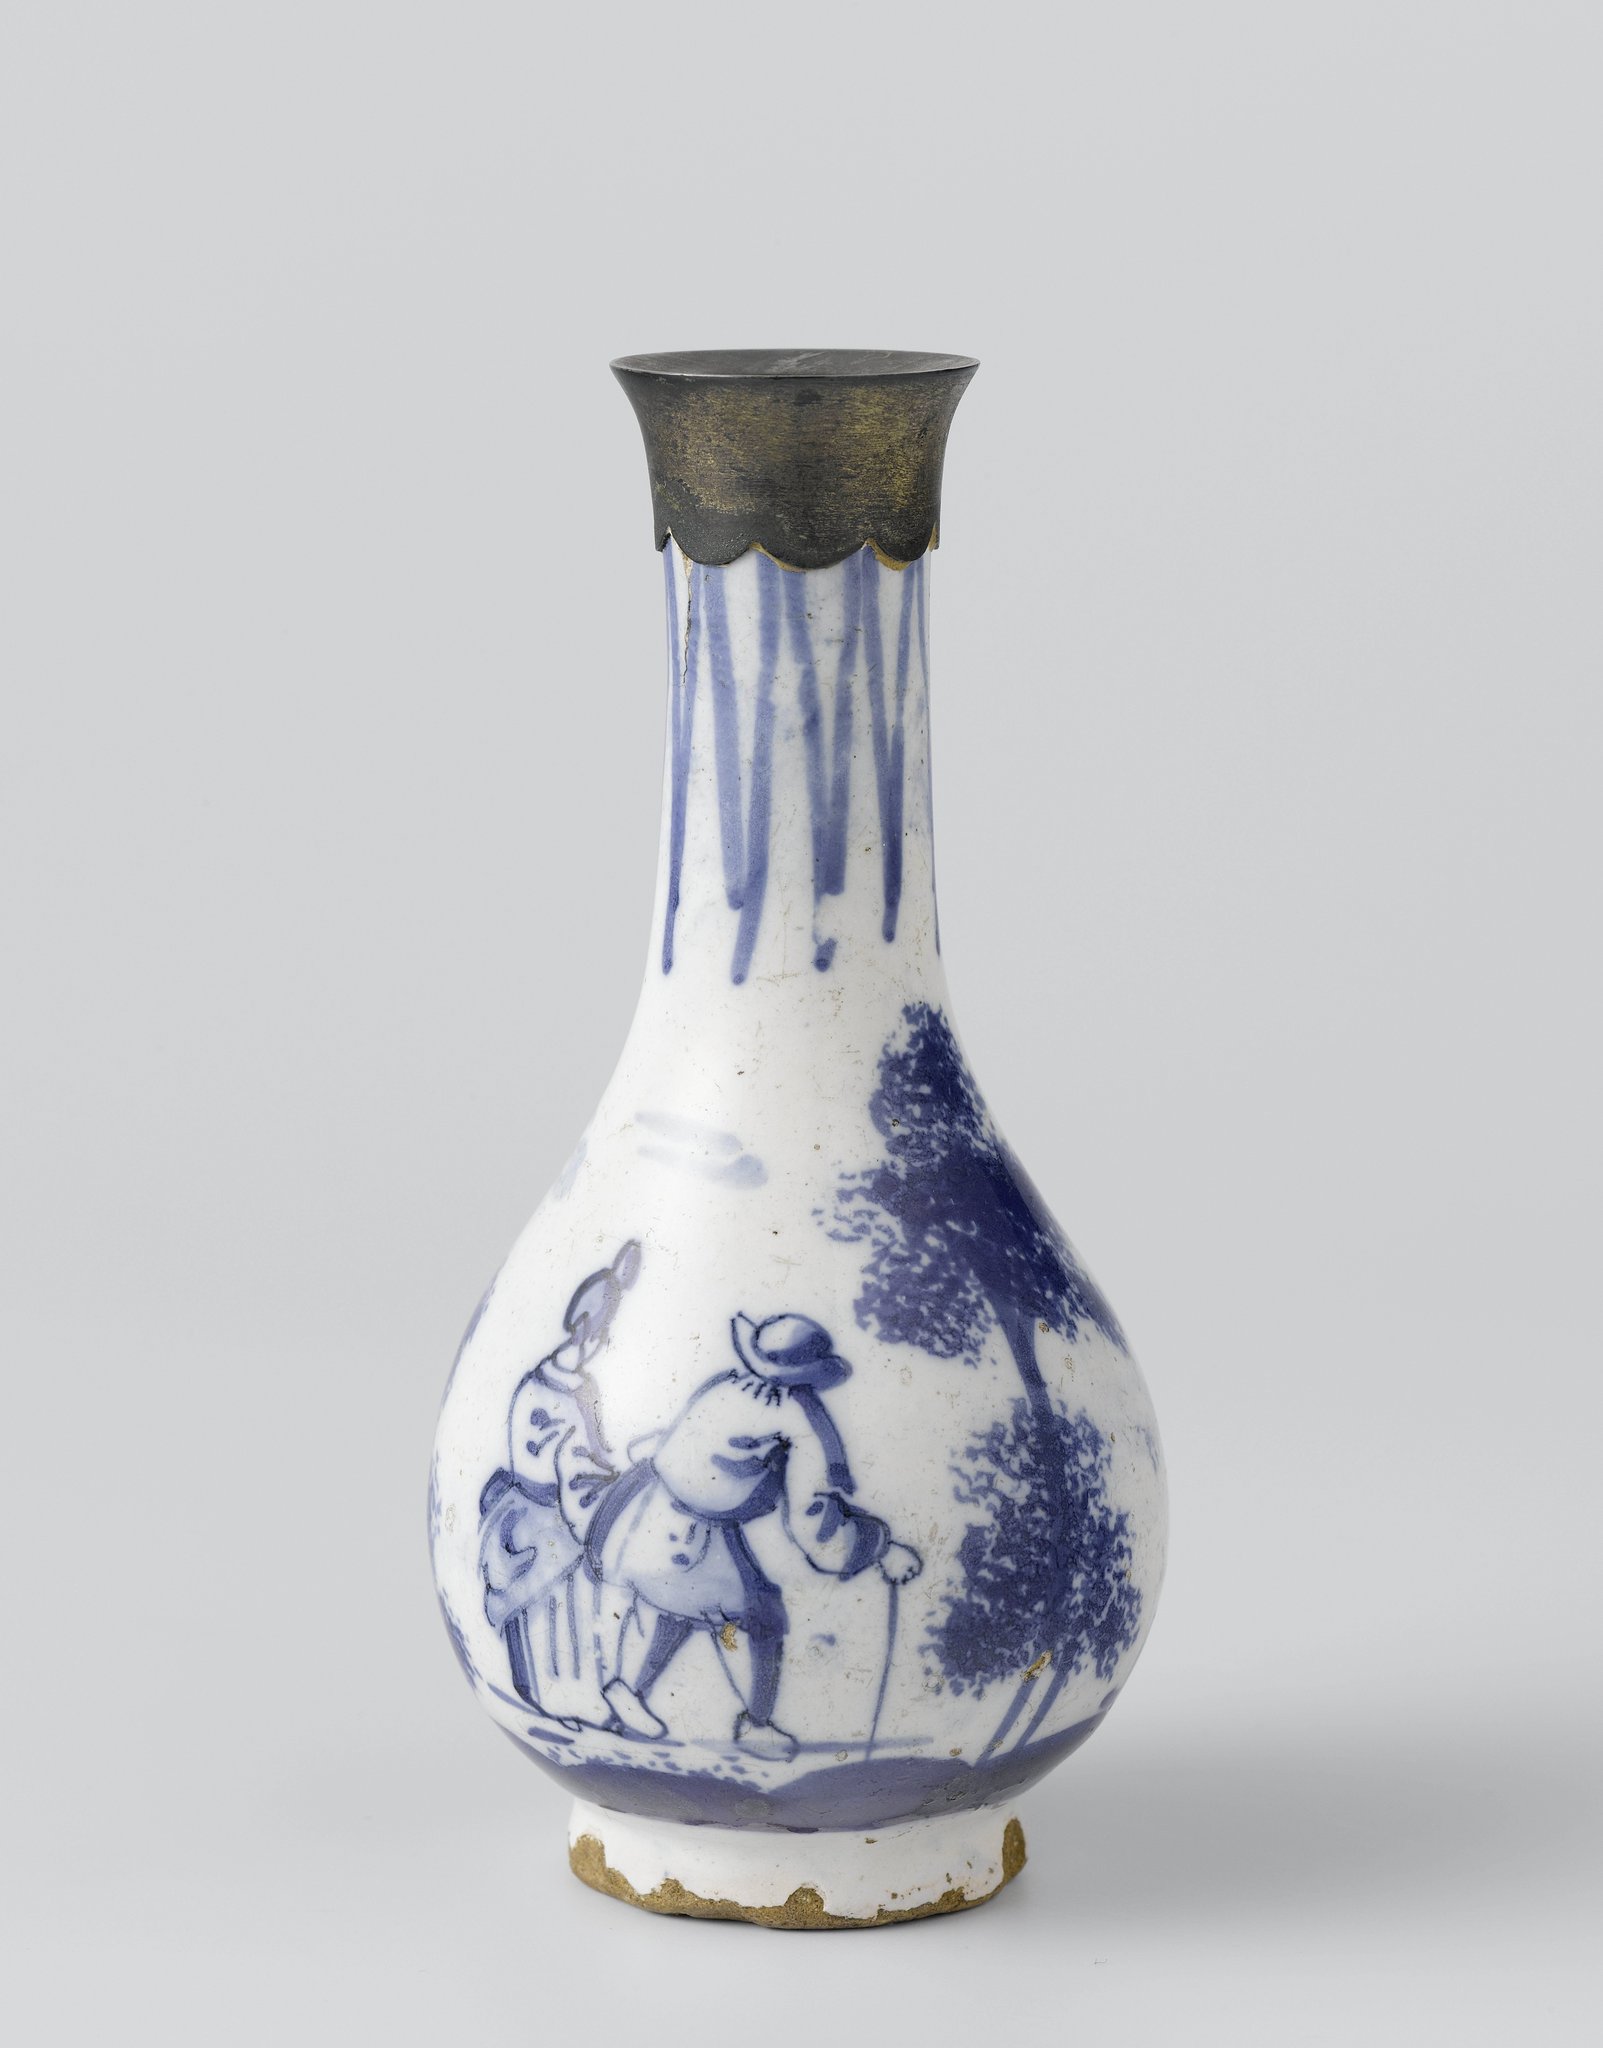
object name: bottle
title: Fles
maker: Anonymous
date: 1700-1725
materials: earthenware, silver, glaze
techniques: painted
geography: delft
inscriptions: mark (possibly false): ‘LVE(ineen)’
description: Fles van blauw beschilderde faience. De fles is van boven met zilver gemonteerd. Op de fles zijn figuren in een landschap geschilderd.